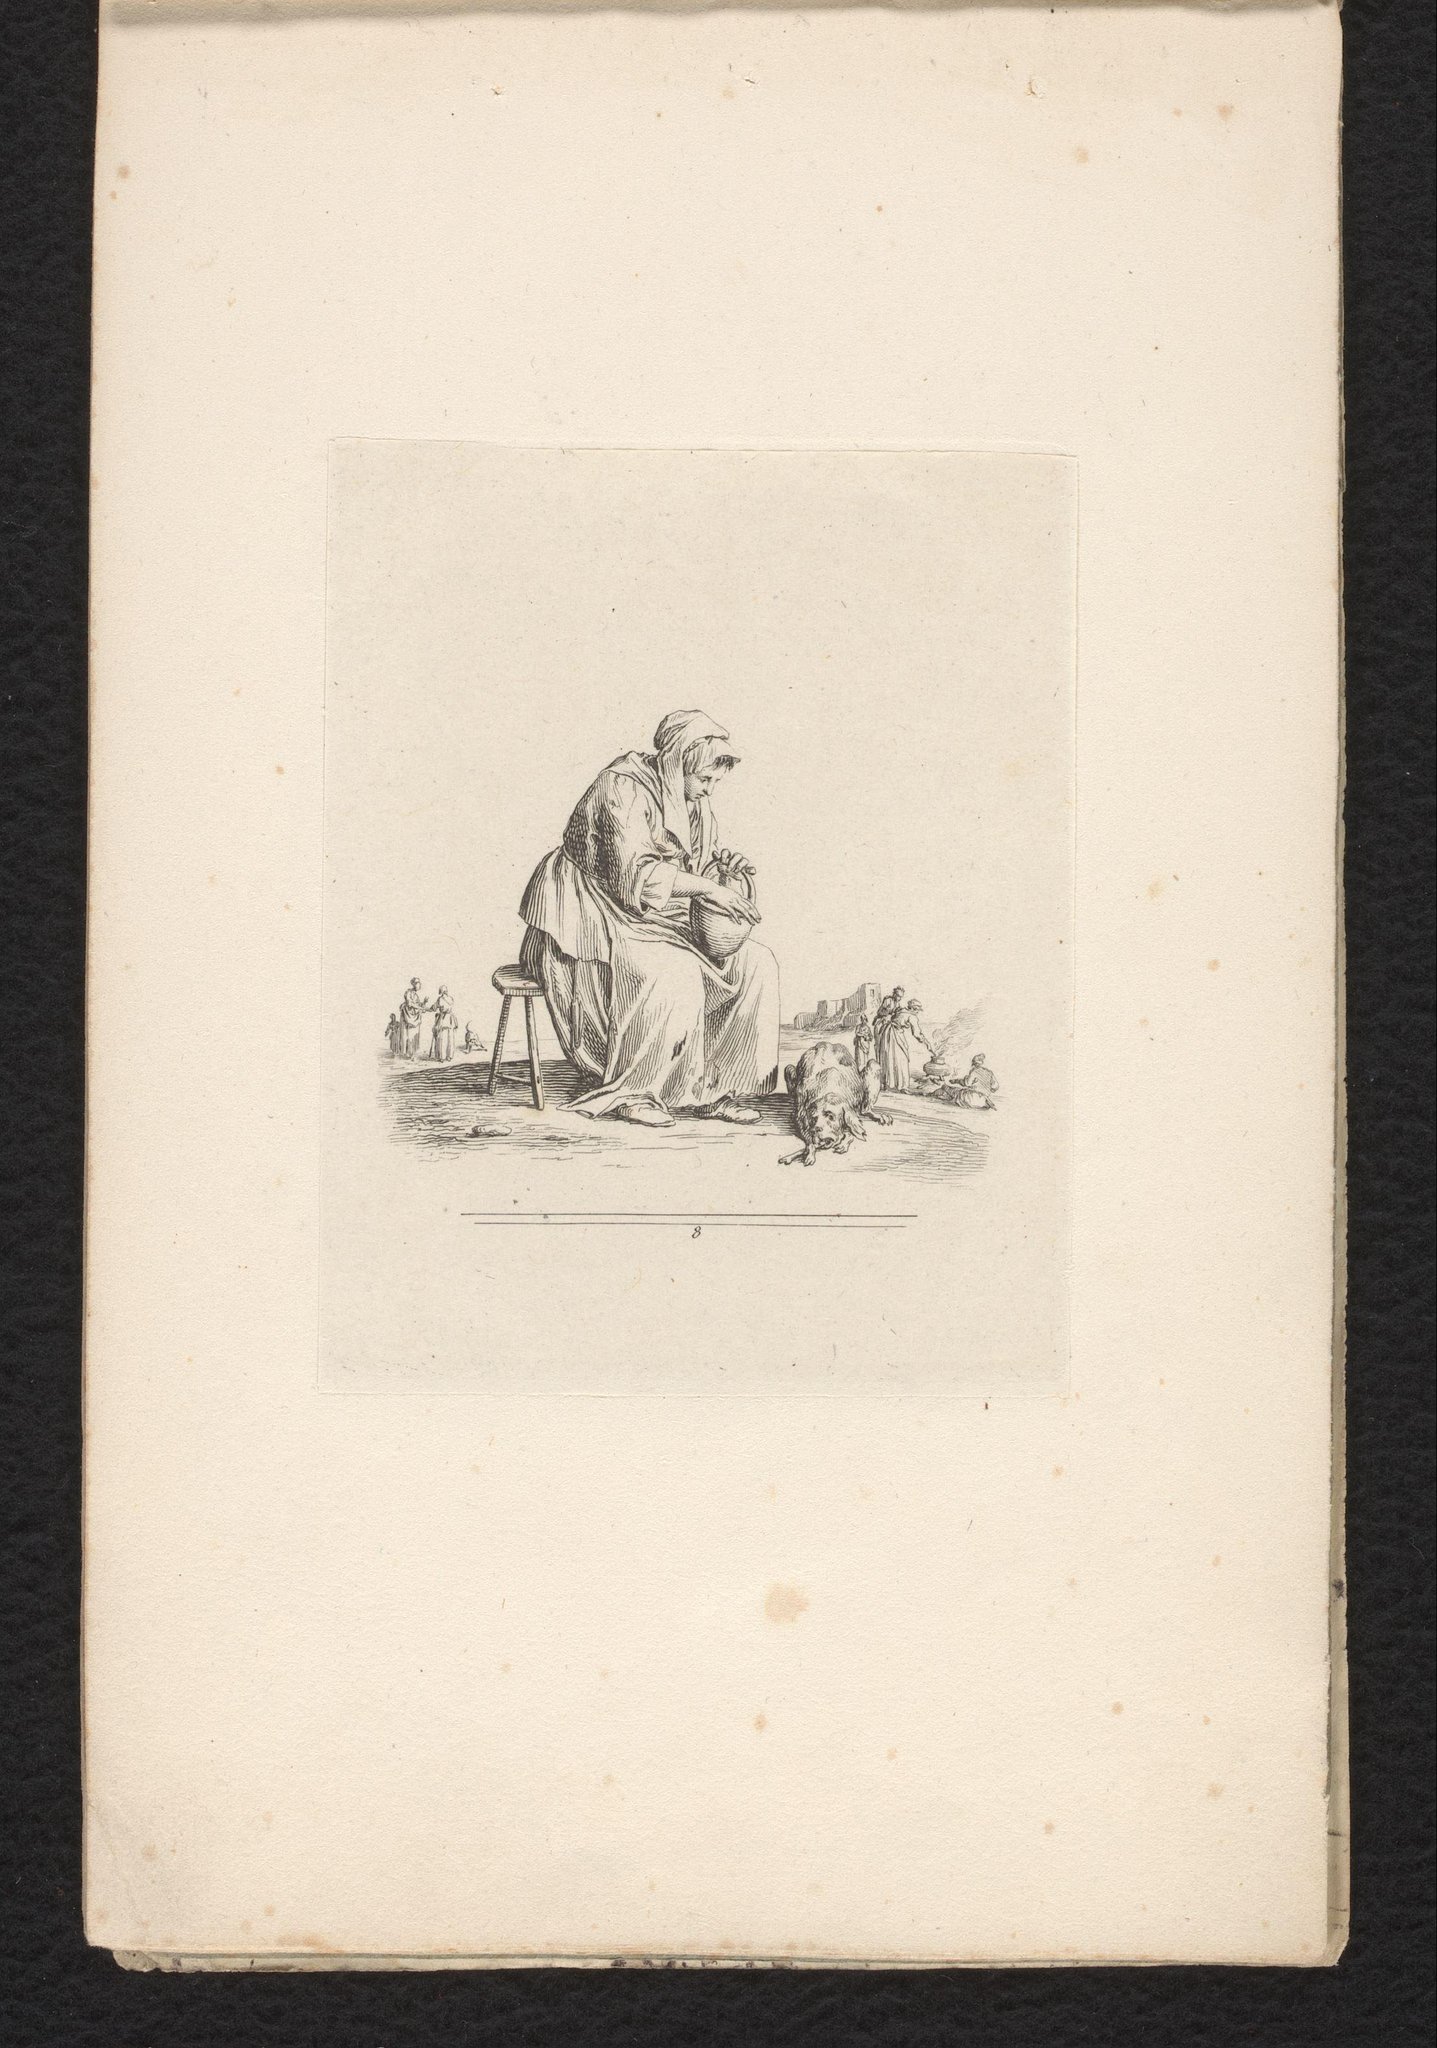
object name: album leaf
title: Suite de Mendiants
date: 1798-1806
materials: paper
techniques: etching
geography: paris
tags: clothed in rags, beggar, dog